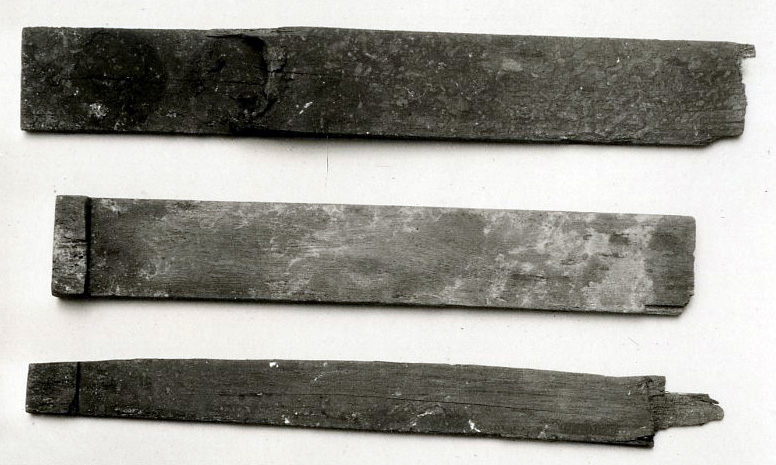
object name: scribal palette fragment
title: Fragment of a scribal palette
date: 1550-1295 BCE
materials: ink, wood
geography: egypt